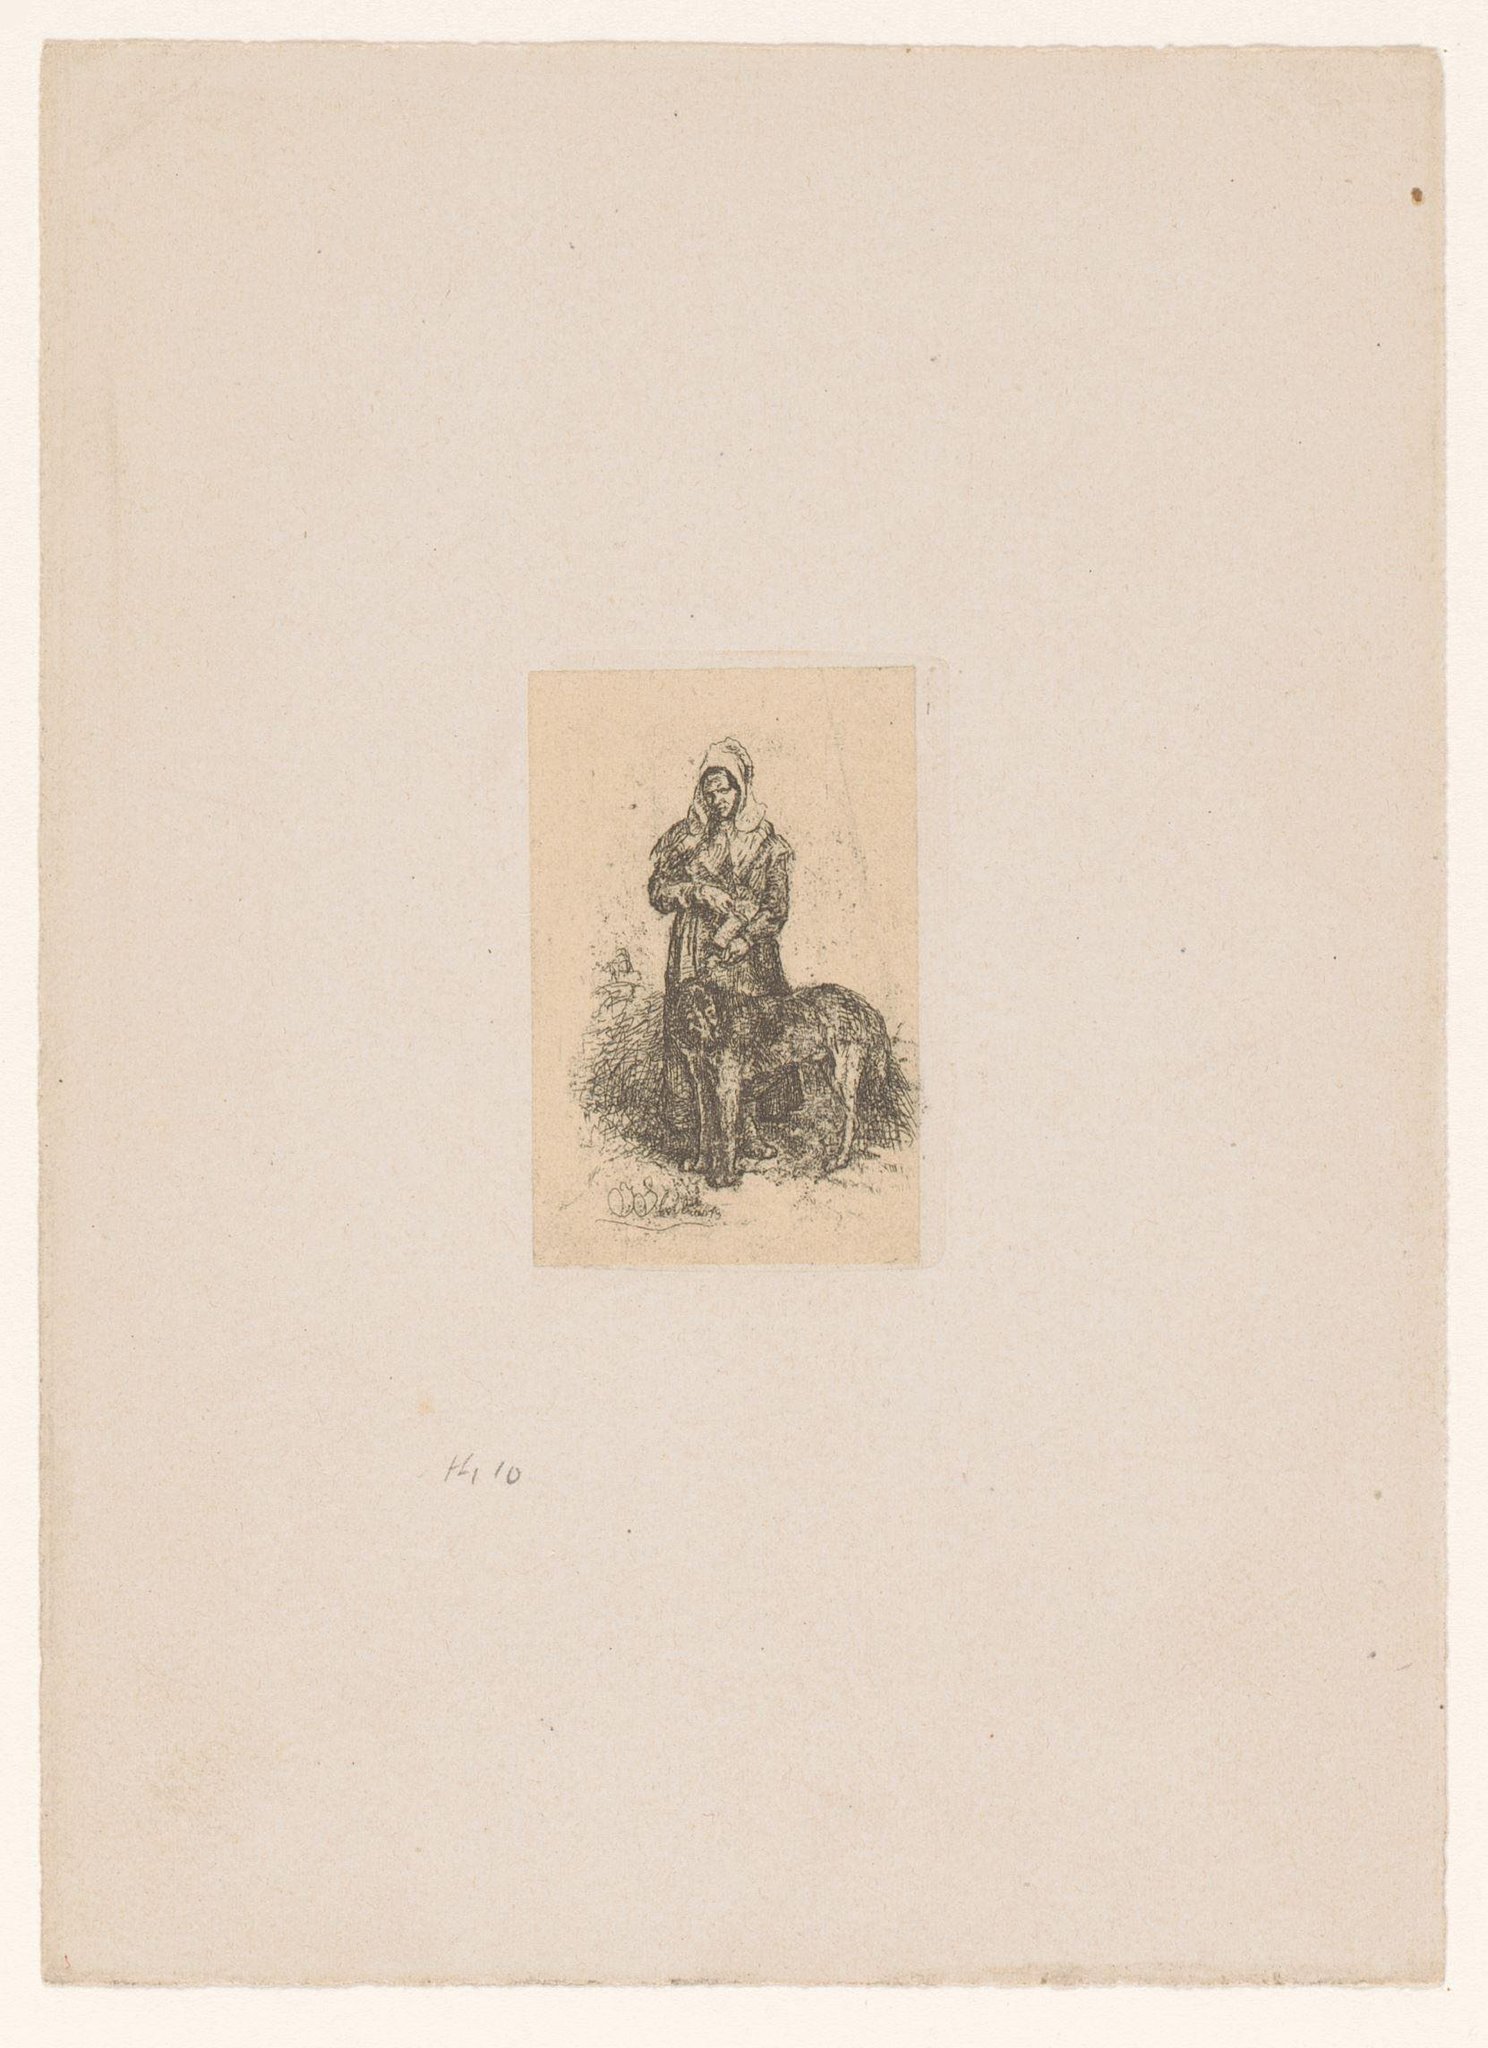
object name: print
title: Boerin met hond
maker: jan stobbaerts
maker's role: draughtsman, print maker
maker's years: 1838-1914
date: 1848-1879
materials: paper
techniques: etching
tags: farmers - aa - female farmer, farmer's wife, dog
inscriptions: collector's mark: Lugt 2228